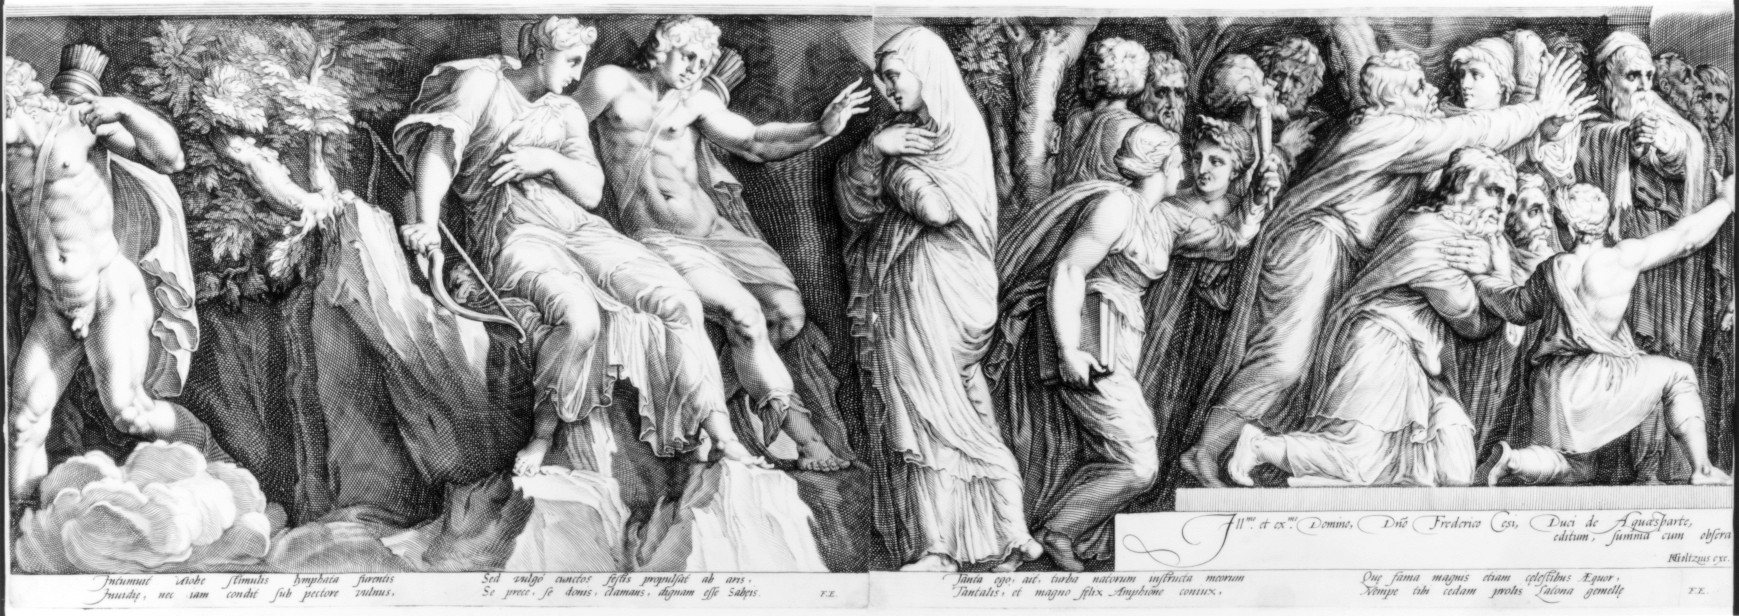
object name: print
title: The Story of Niobe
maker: jan saenredam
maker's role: artist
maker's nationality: netherlandish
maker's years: 1565-1607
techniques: engraving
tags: men,male nudes,women